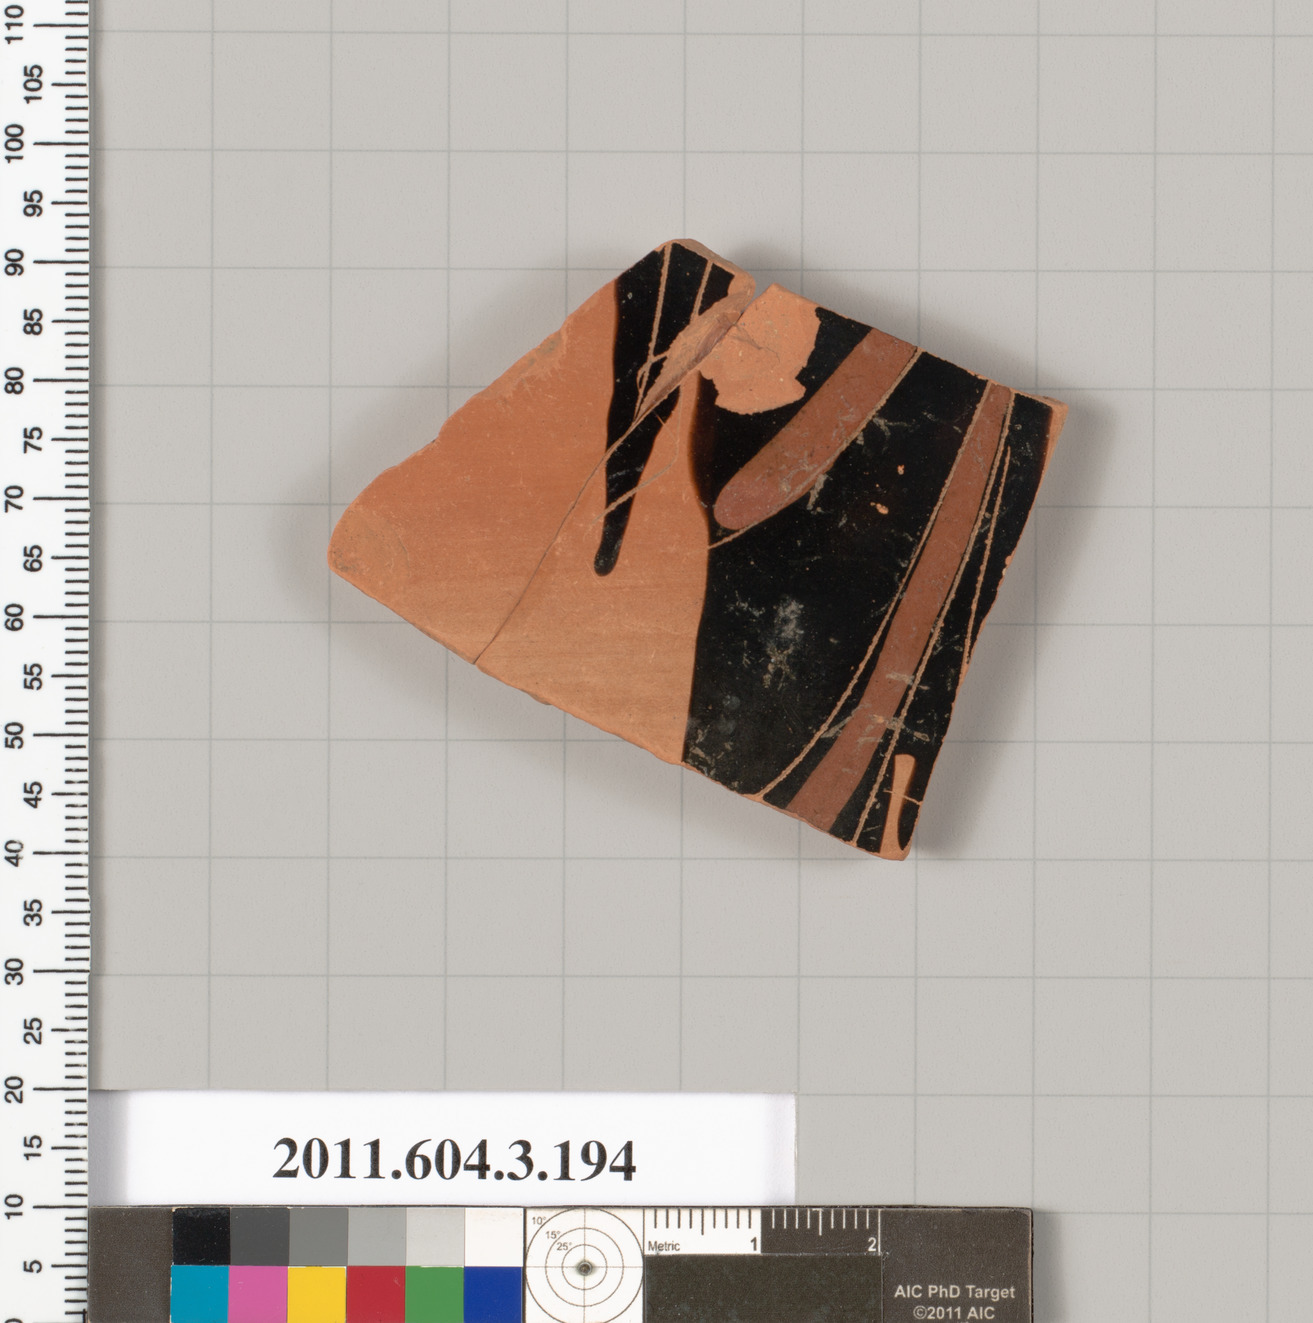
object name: neck amphora fragment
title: Terracotta fragment of a neck-amphora (jar)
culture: greek, attic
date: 525-501 BCE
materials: terracotta